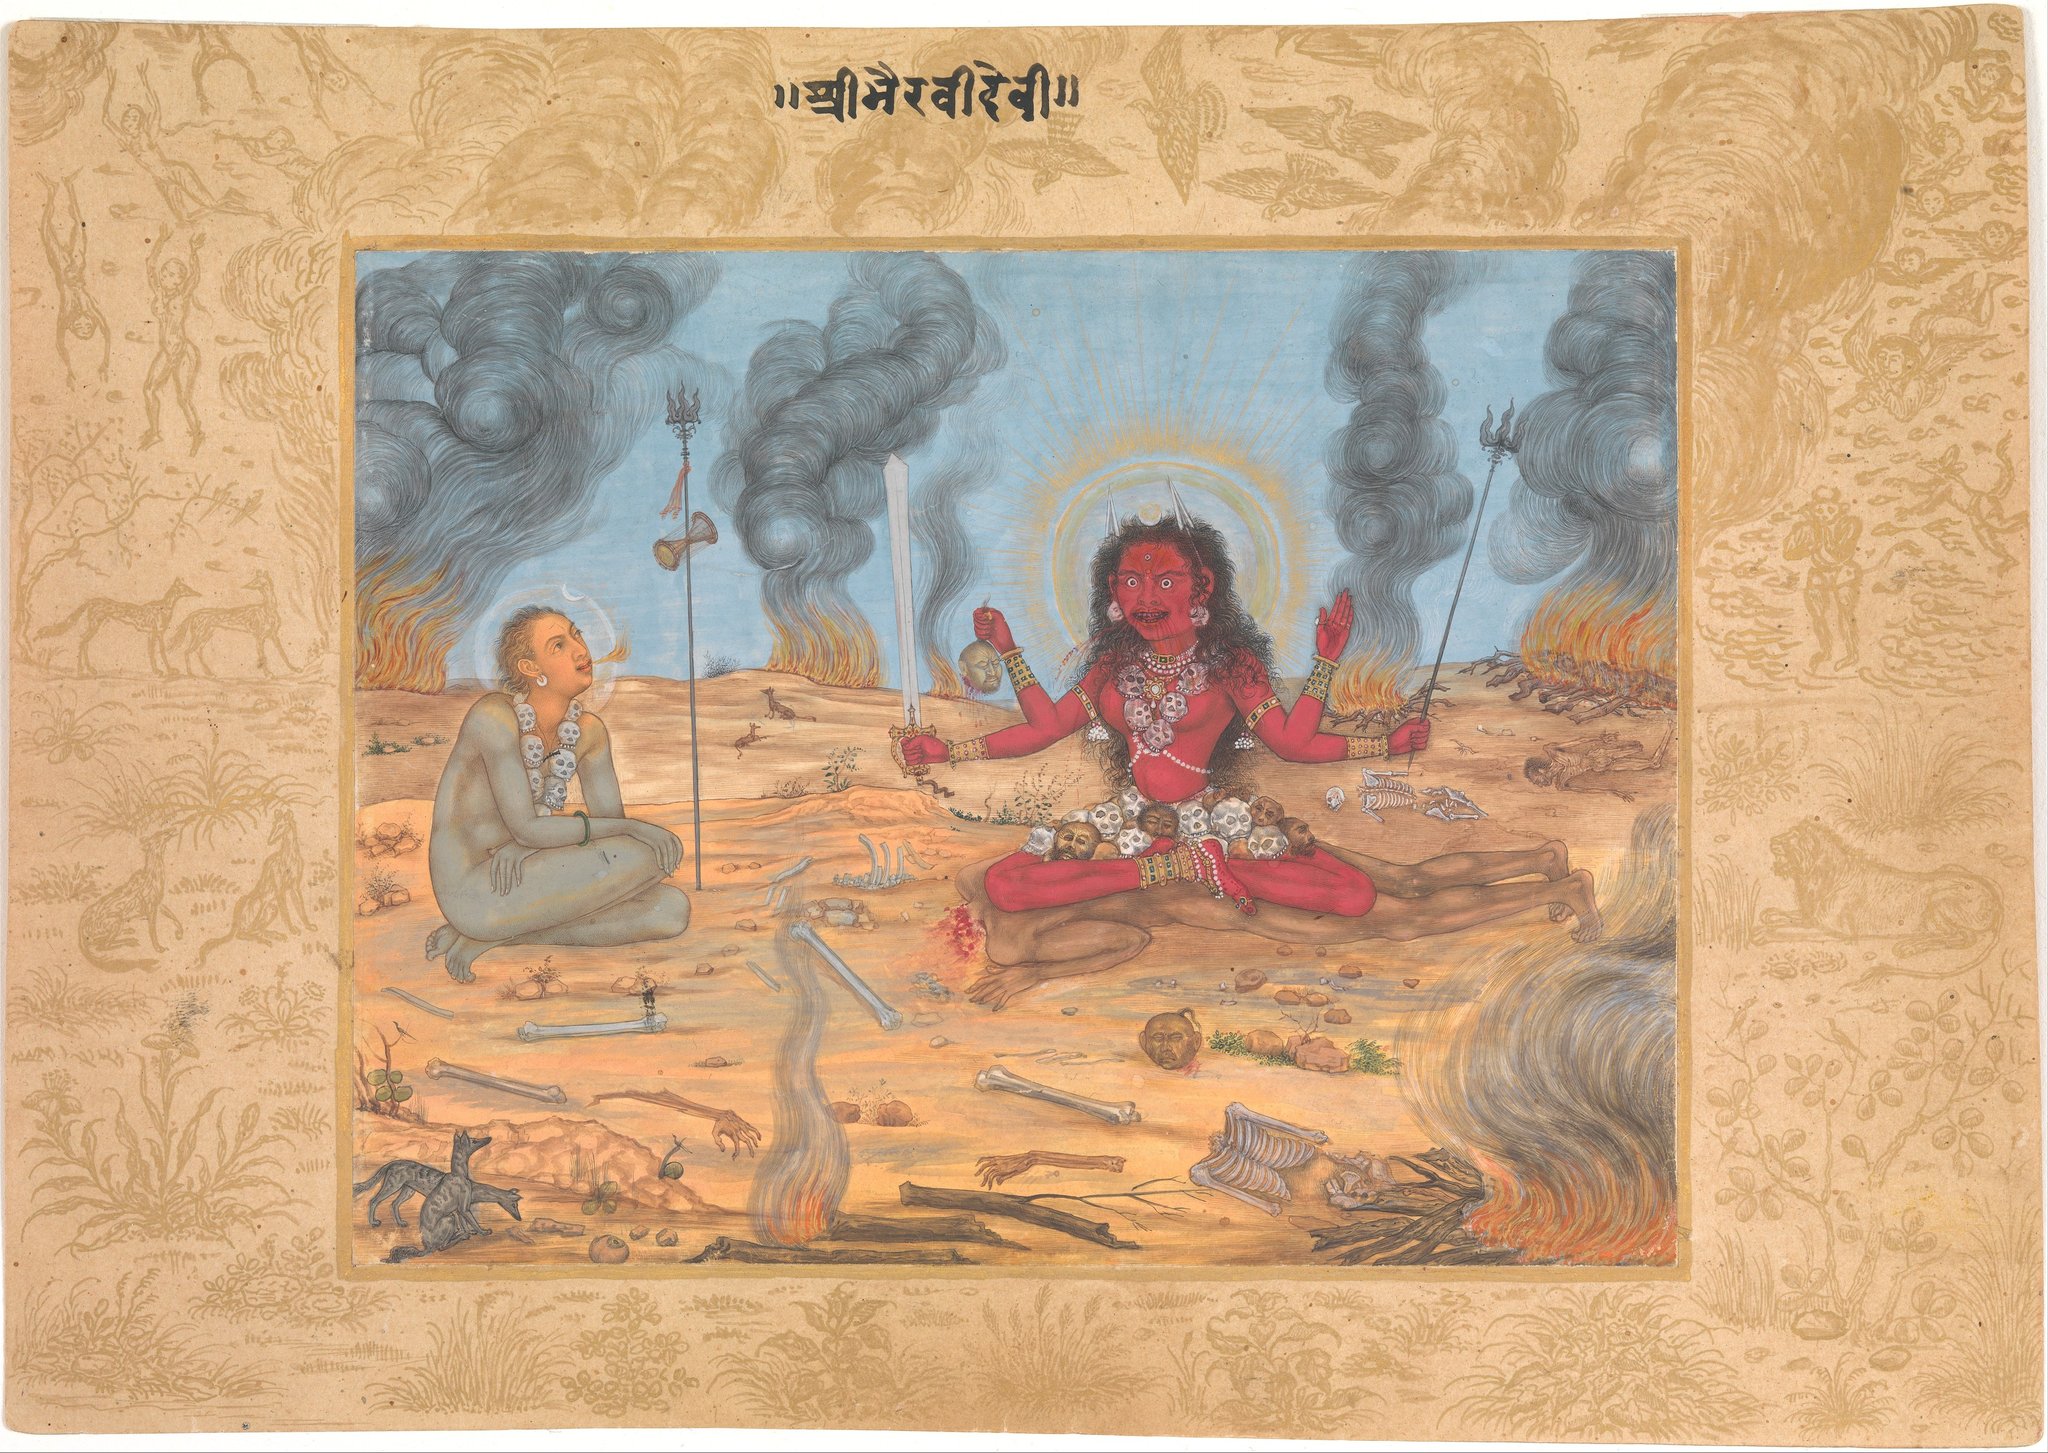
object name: illustrated album leaf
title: The Goddess Bhairavi Devi with Shiva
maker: payag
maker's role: artist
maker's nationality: indian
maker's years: 1586-1658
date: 1630-1635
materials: gold, paper, watercolor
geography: india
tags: skulls,fire,goddess,shiva